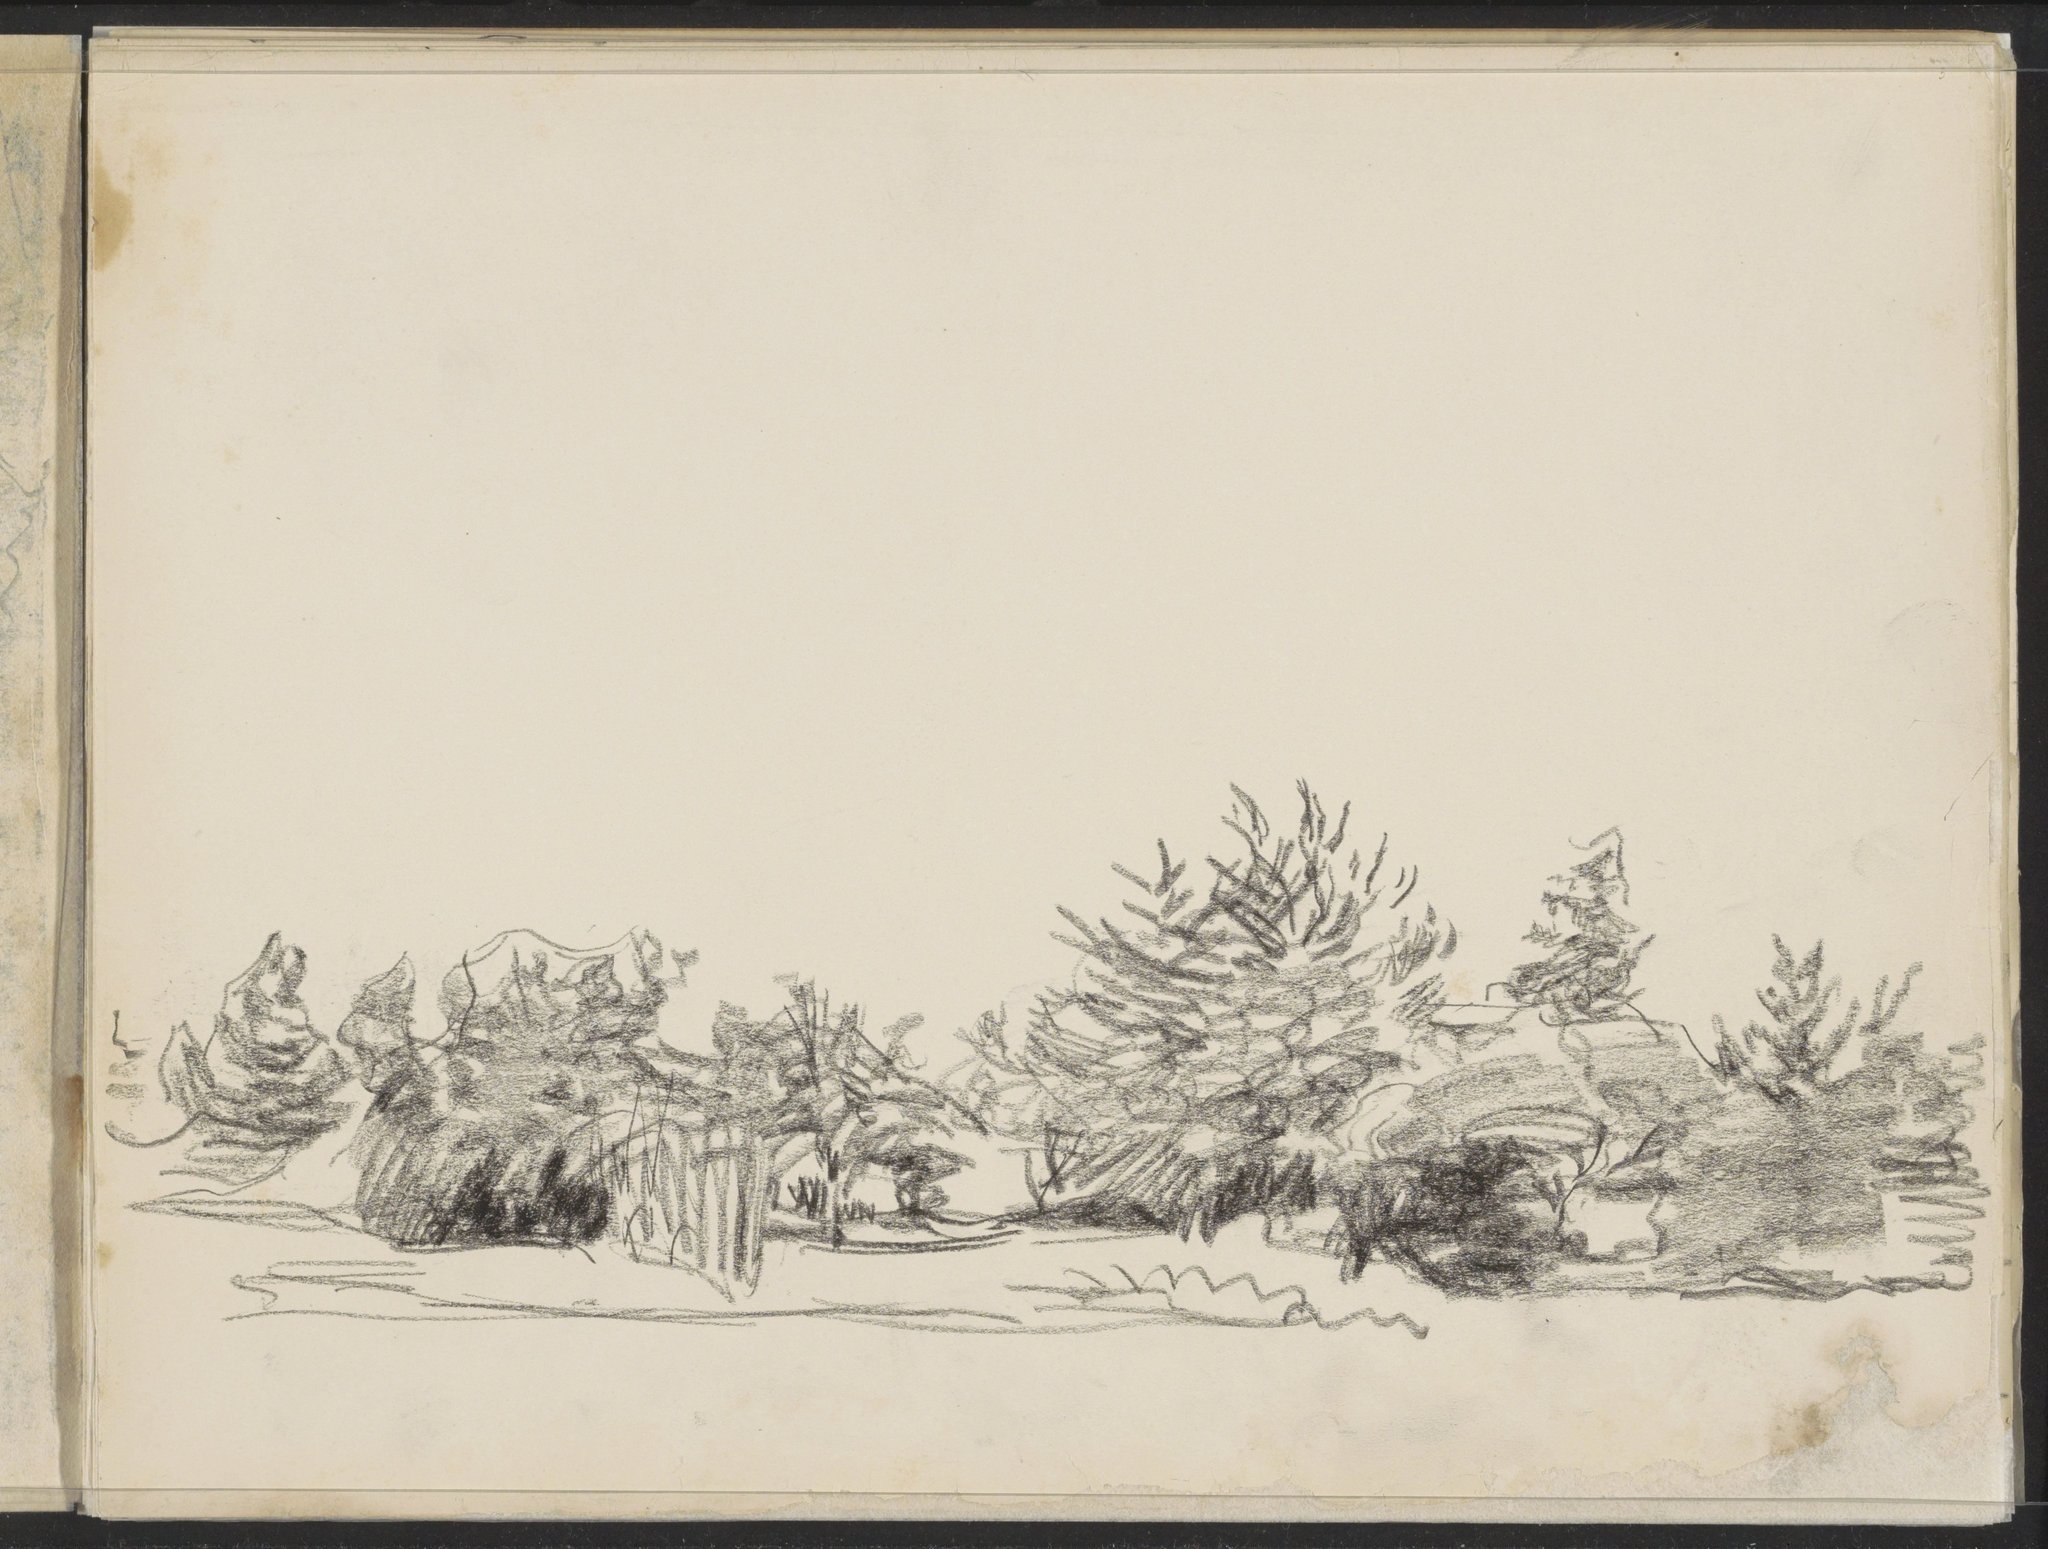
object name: sketchbook leaf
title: Bomen en struikgewas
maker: willem bastiaan tholen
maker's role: draughtsman, painter, print maker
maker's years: 1860-1931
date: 1870-1931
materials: chalk, paper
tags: trees, shrubs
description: Blad 3 recto uit een schetsboek met 28 bladen.